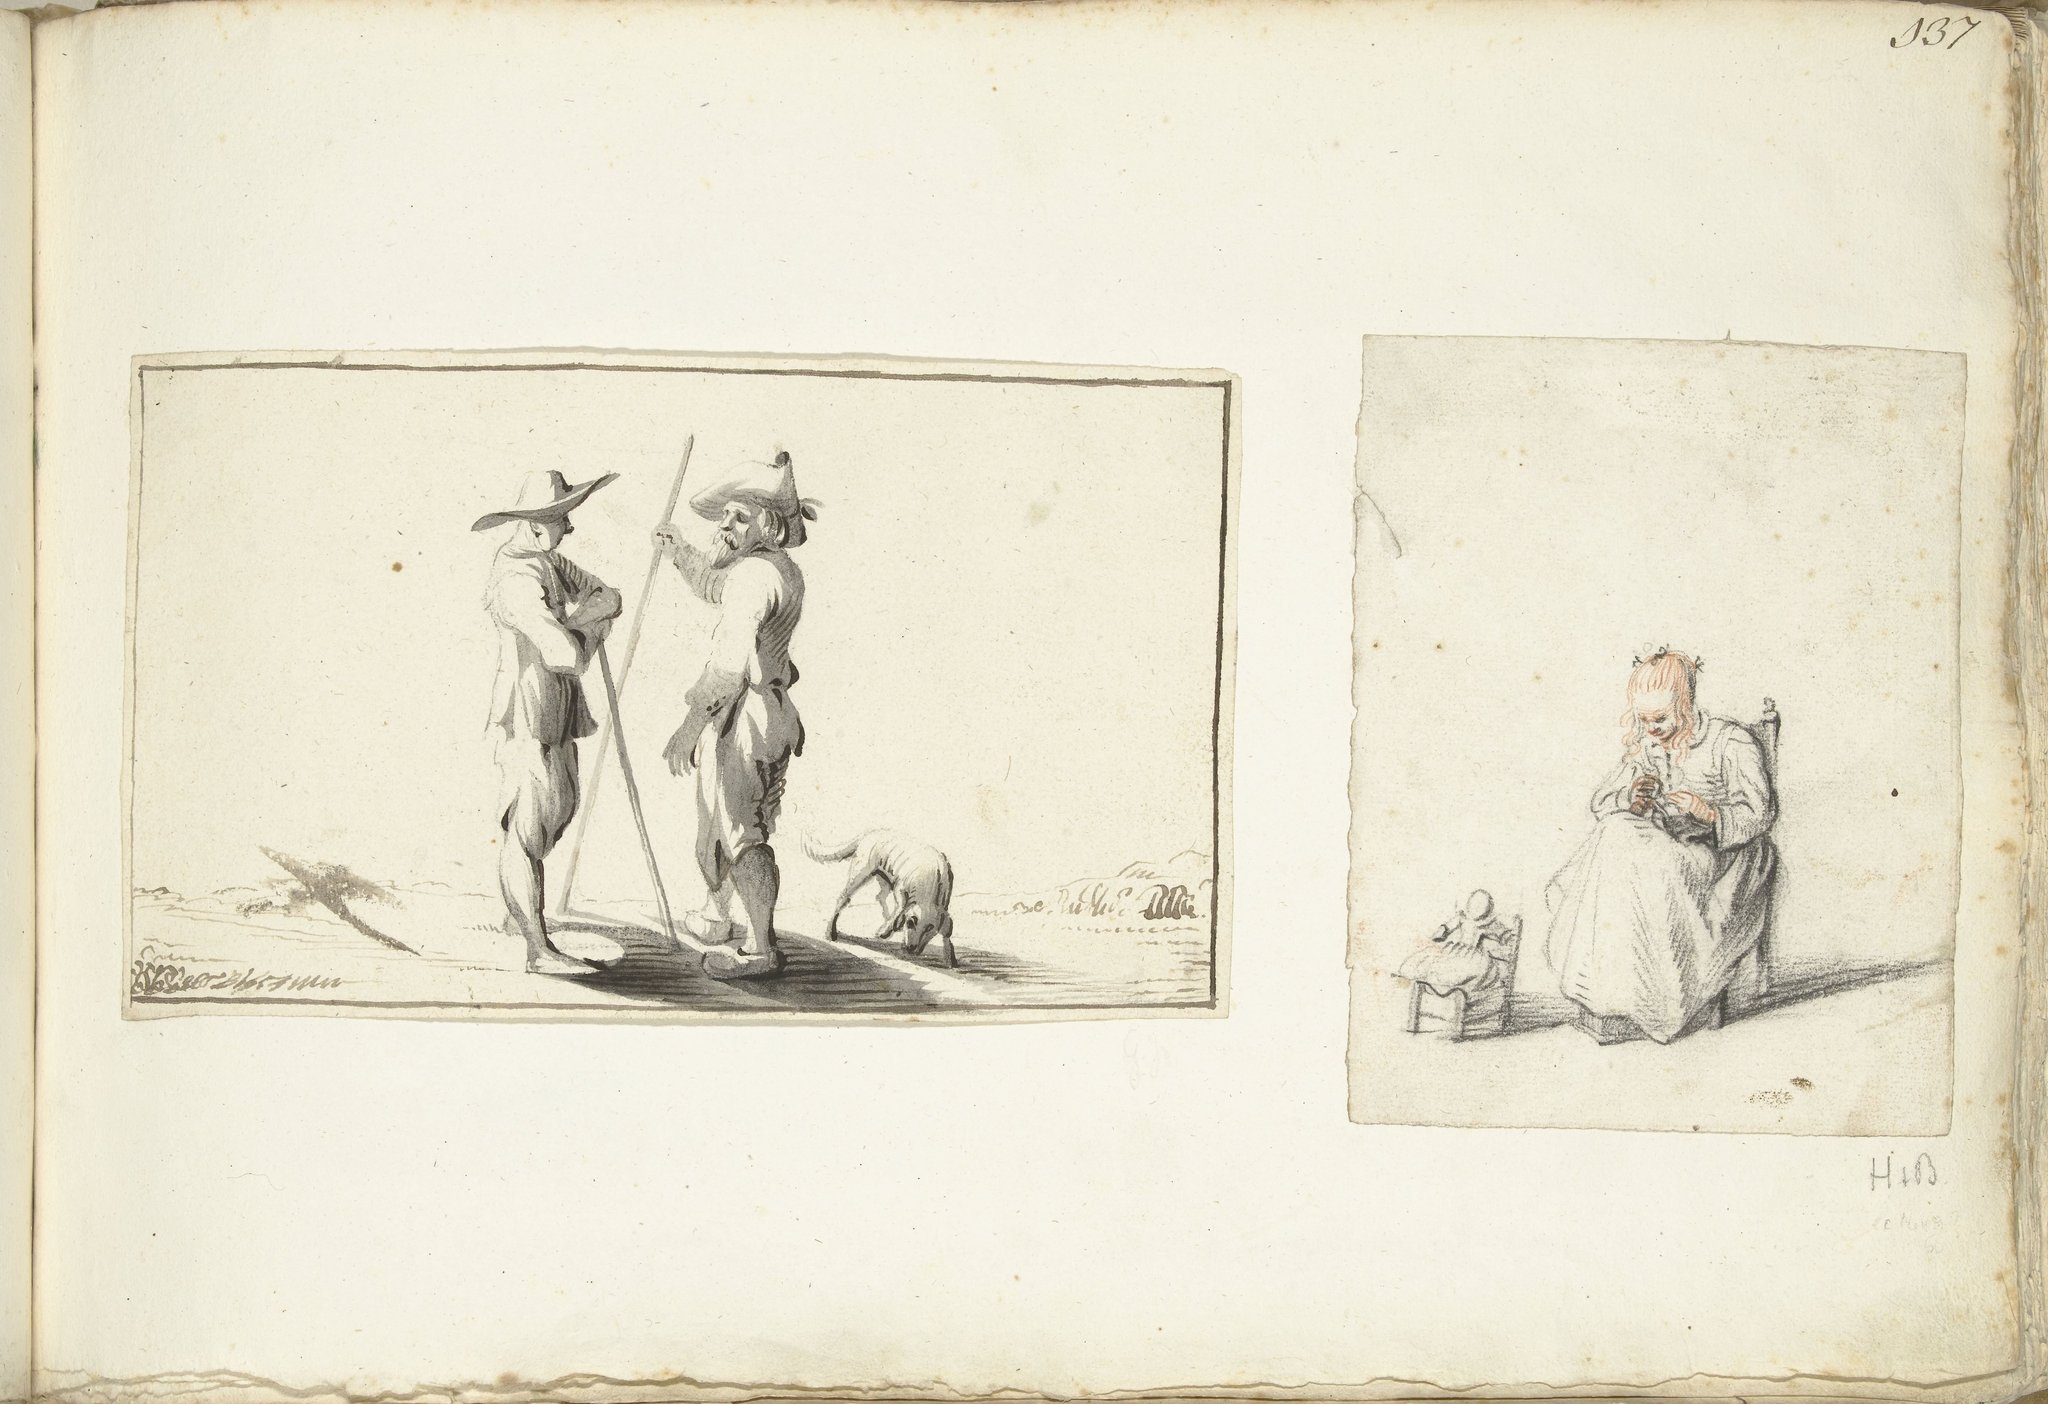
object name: drawing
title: Twee staande mannen en een naaiend meisje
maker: harmen ter borch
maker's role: draughtsman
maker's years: 1638-1677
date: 1648-1677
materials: chalk, ink, paper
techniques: brush, pen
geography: zwolle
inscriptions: annotation: ‘HtB’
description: Tekening naast een andere tekening geplakt in het Familie-plakboek.